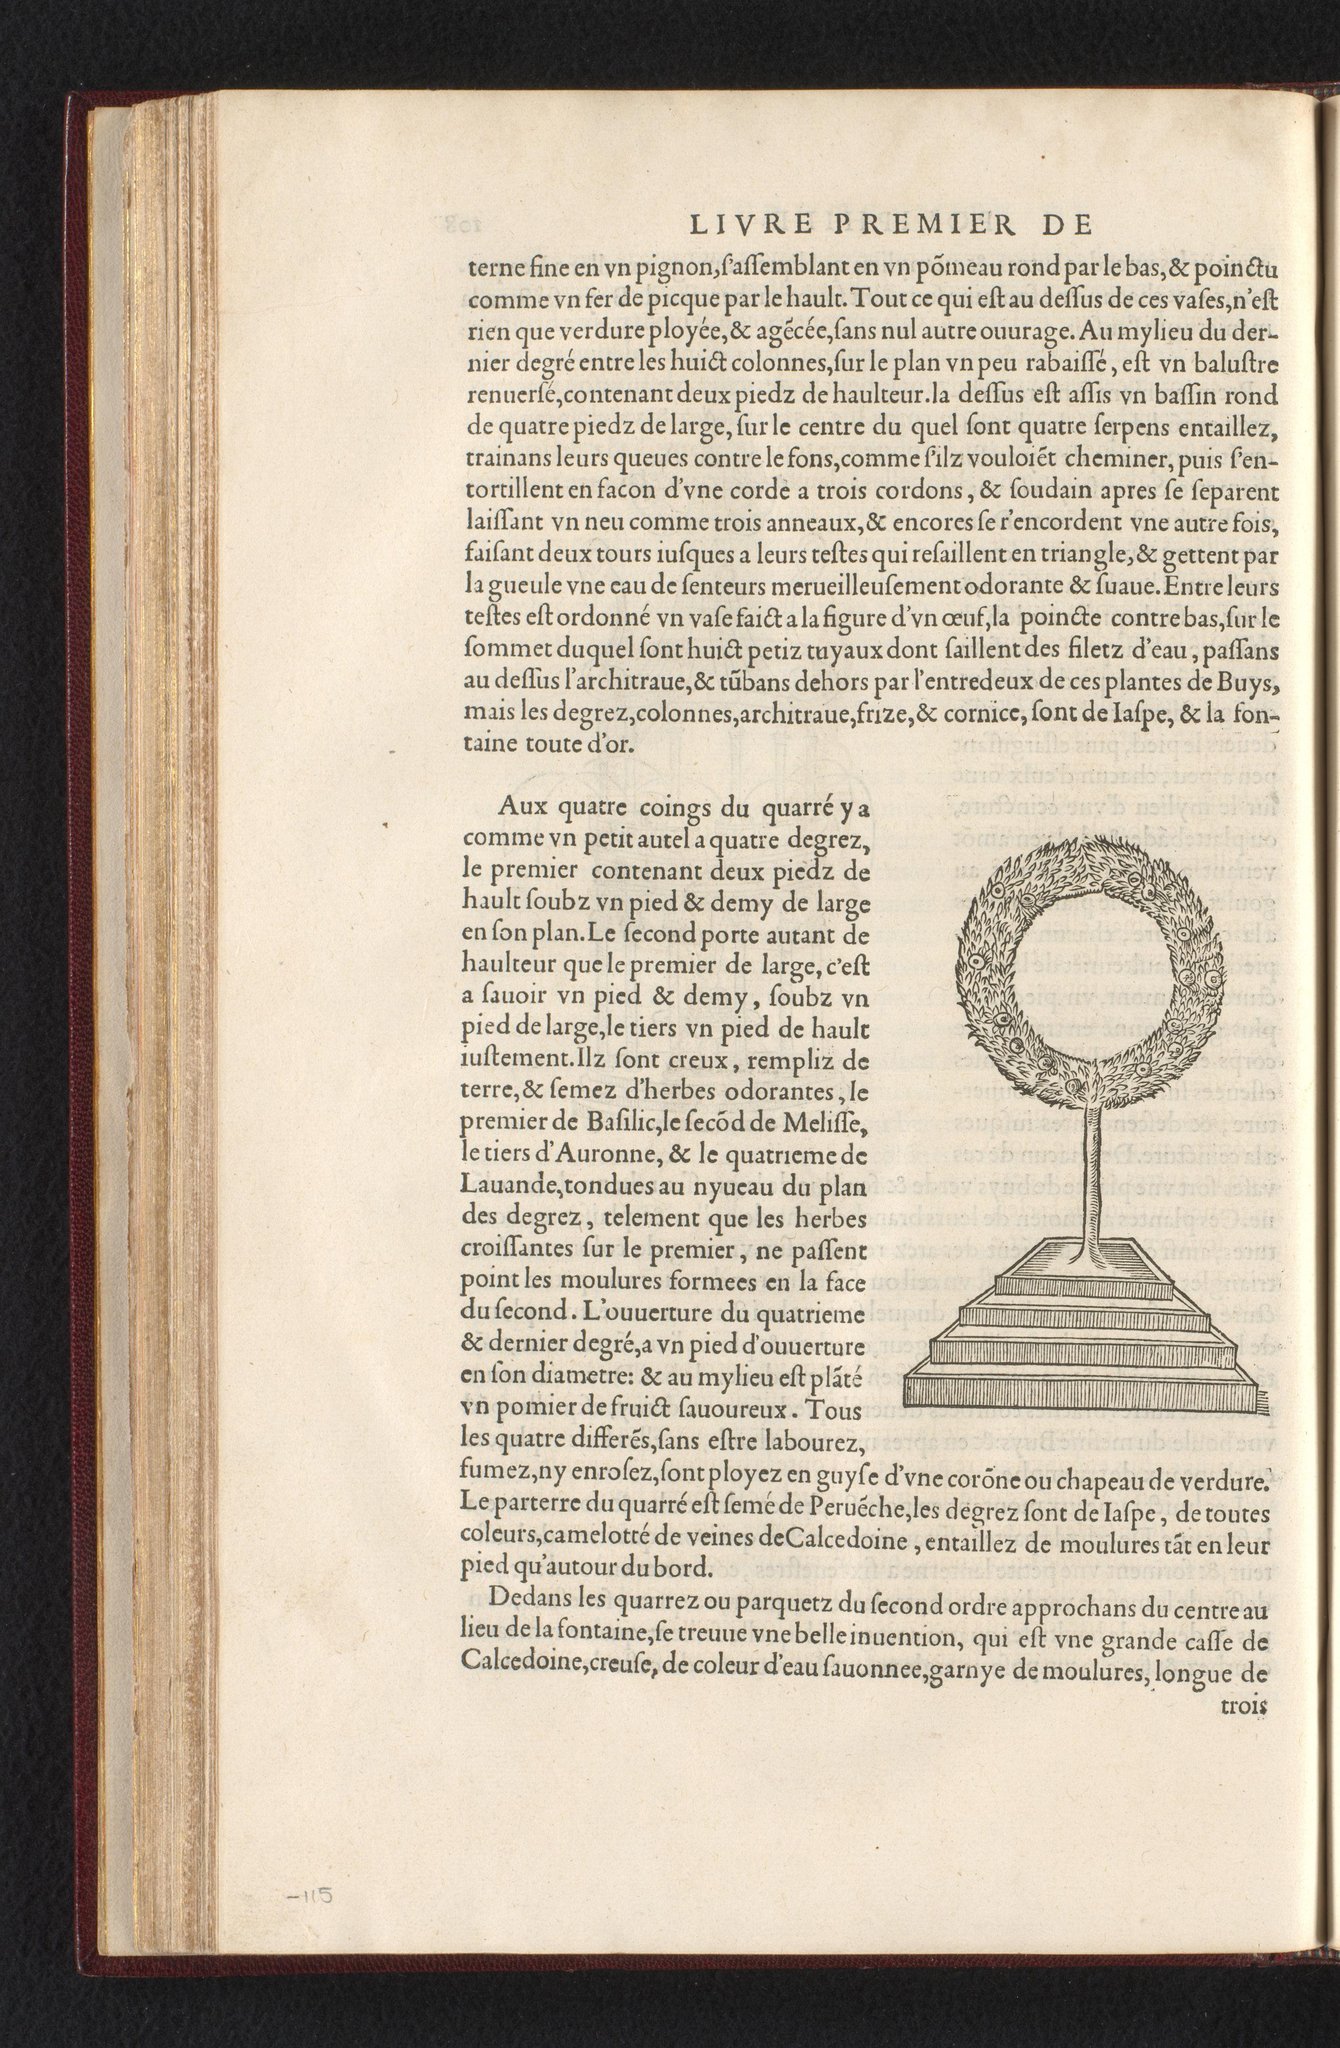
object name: book illustration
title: Boom in een ring gesnoeid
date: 1546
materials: paper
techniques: letterpress printing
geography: paris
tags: trees, (scenes from) specific works of literature: colonna, hypnerotomachia poliphili, pruning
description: Prent uit: Colonna, Francesco. Hypnerotomachie ou discours du songe de Poliphile, deduisant comme amour le combat a l'occasion de Polia. Parijs: Jacques Kerver, 1546, verso fol. 108.